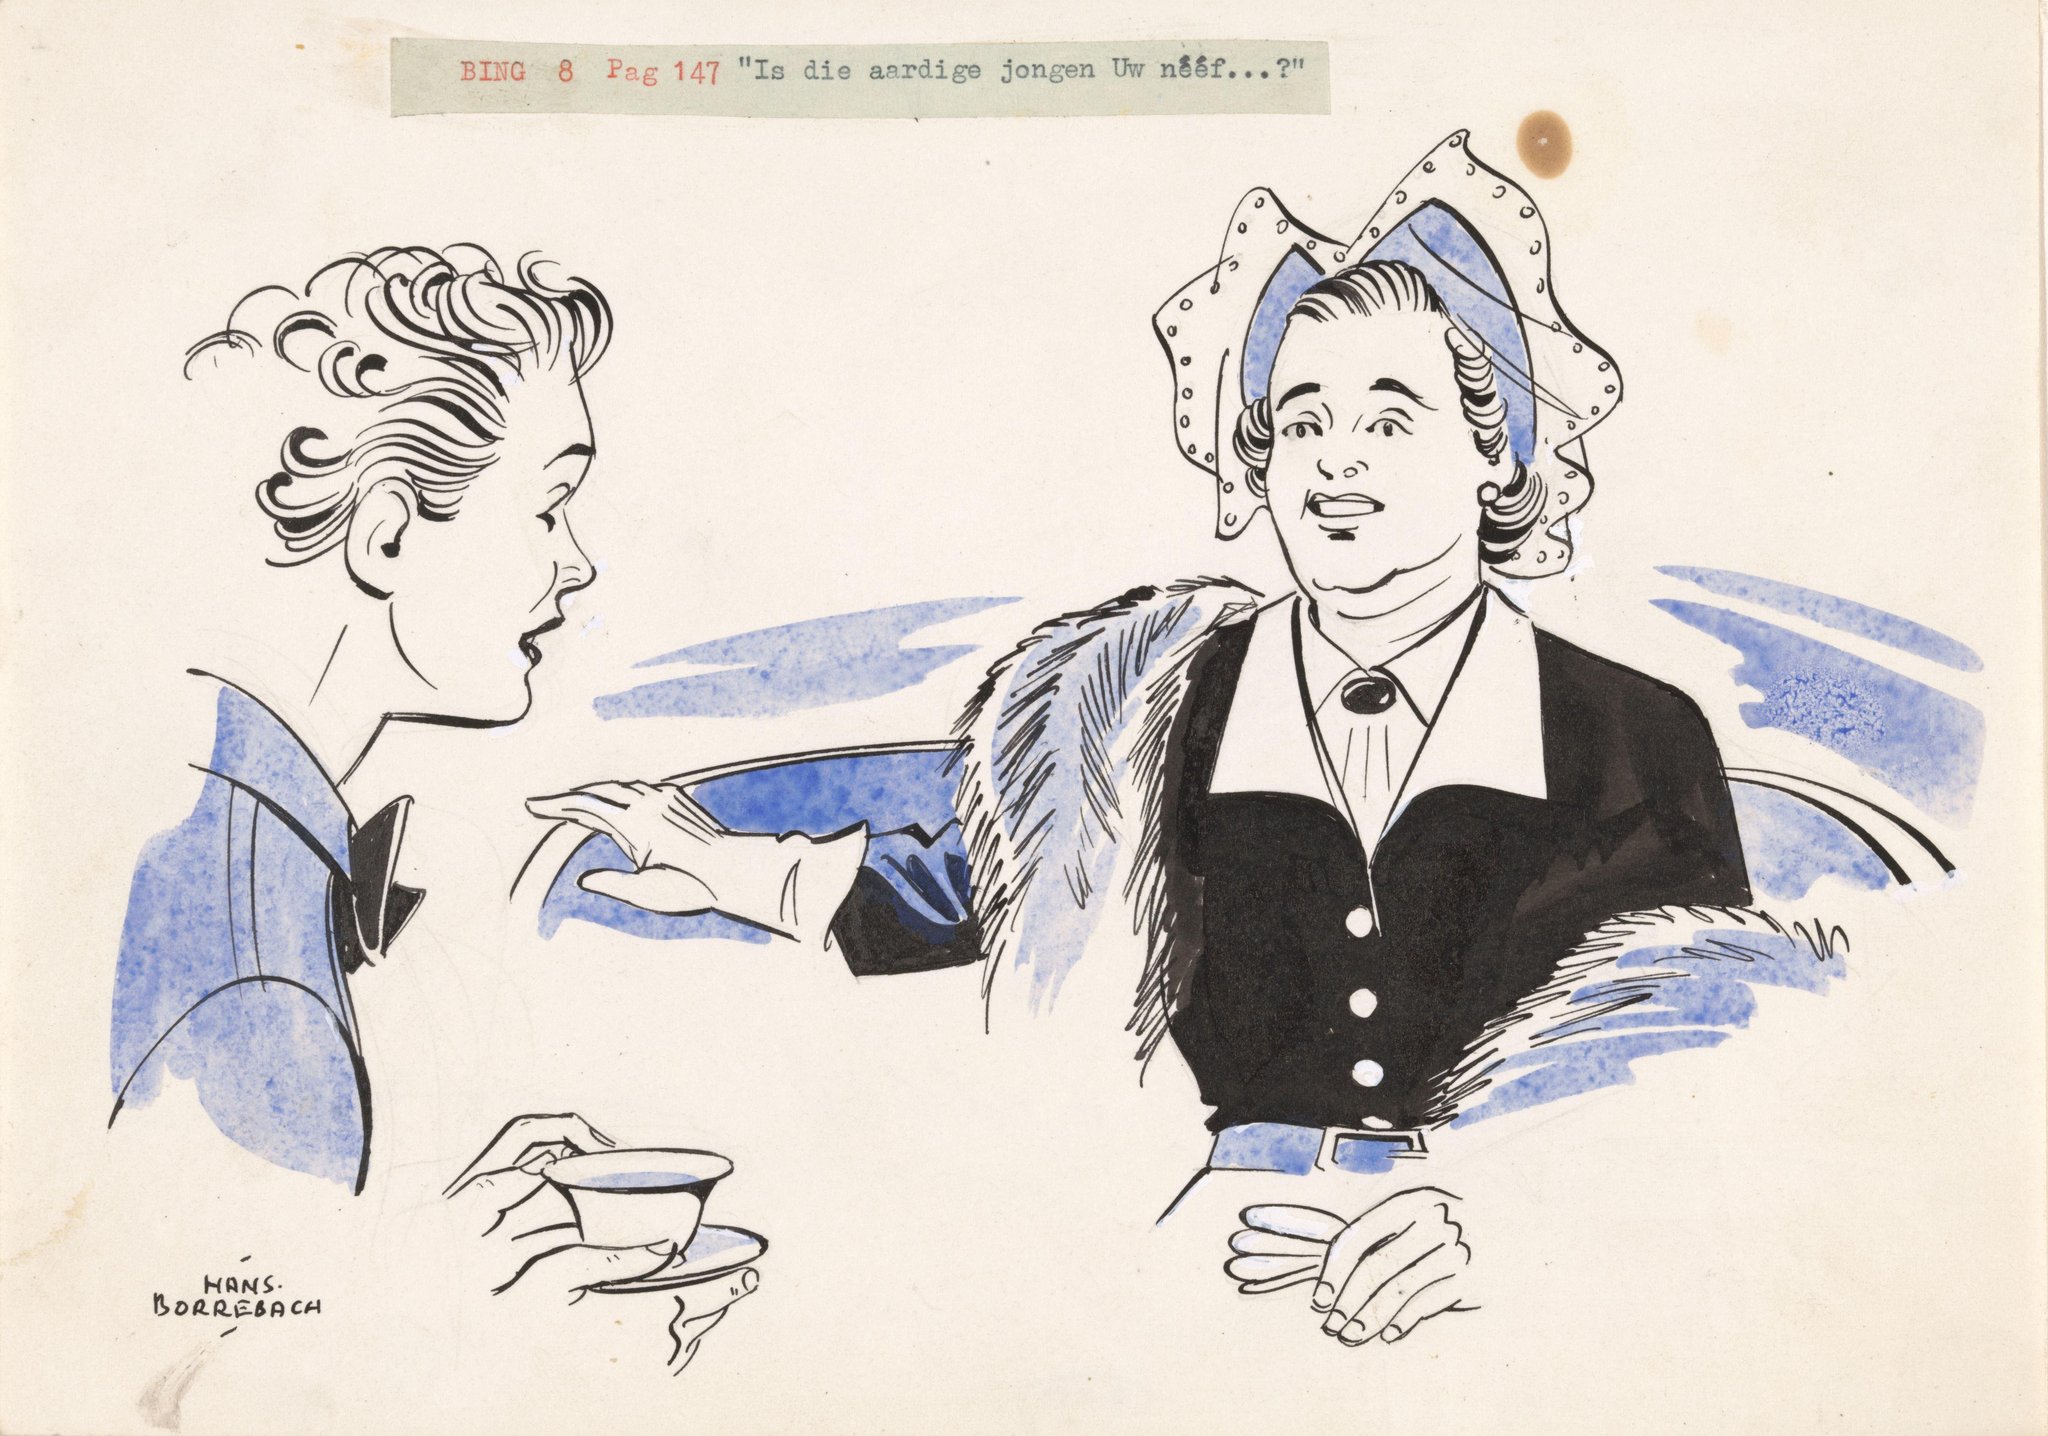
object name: drawing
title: Twee vrouwen in gesprek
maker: hans borrebach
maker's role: draughtsman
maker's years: 1903-1991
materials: paint, ink, paper, pencil, watercolor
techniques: brush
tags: visiting; receiving guests; elegant company, cup and saucer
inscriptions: :, collector's mark: Lugt 2228a, signature: ‘HANS./ BORREBACH’, annotation: ‘BING 8 pag 147 "Is die aardige jongen Uw nééf ...?"’, number:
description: Een vrouw met een kop en schotel in de hand kijkt naar een zittende vrouw met een hoed, handschoenen en bontkraag.